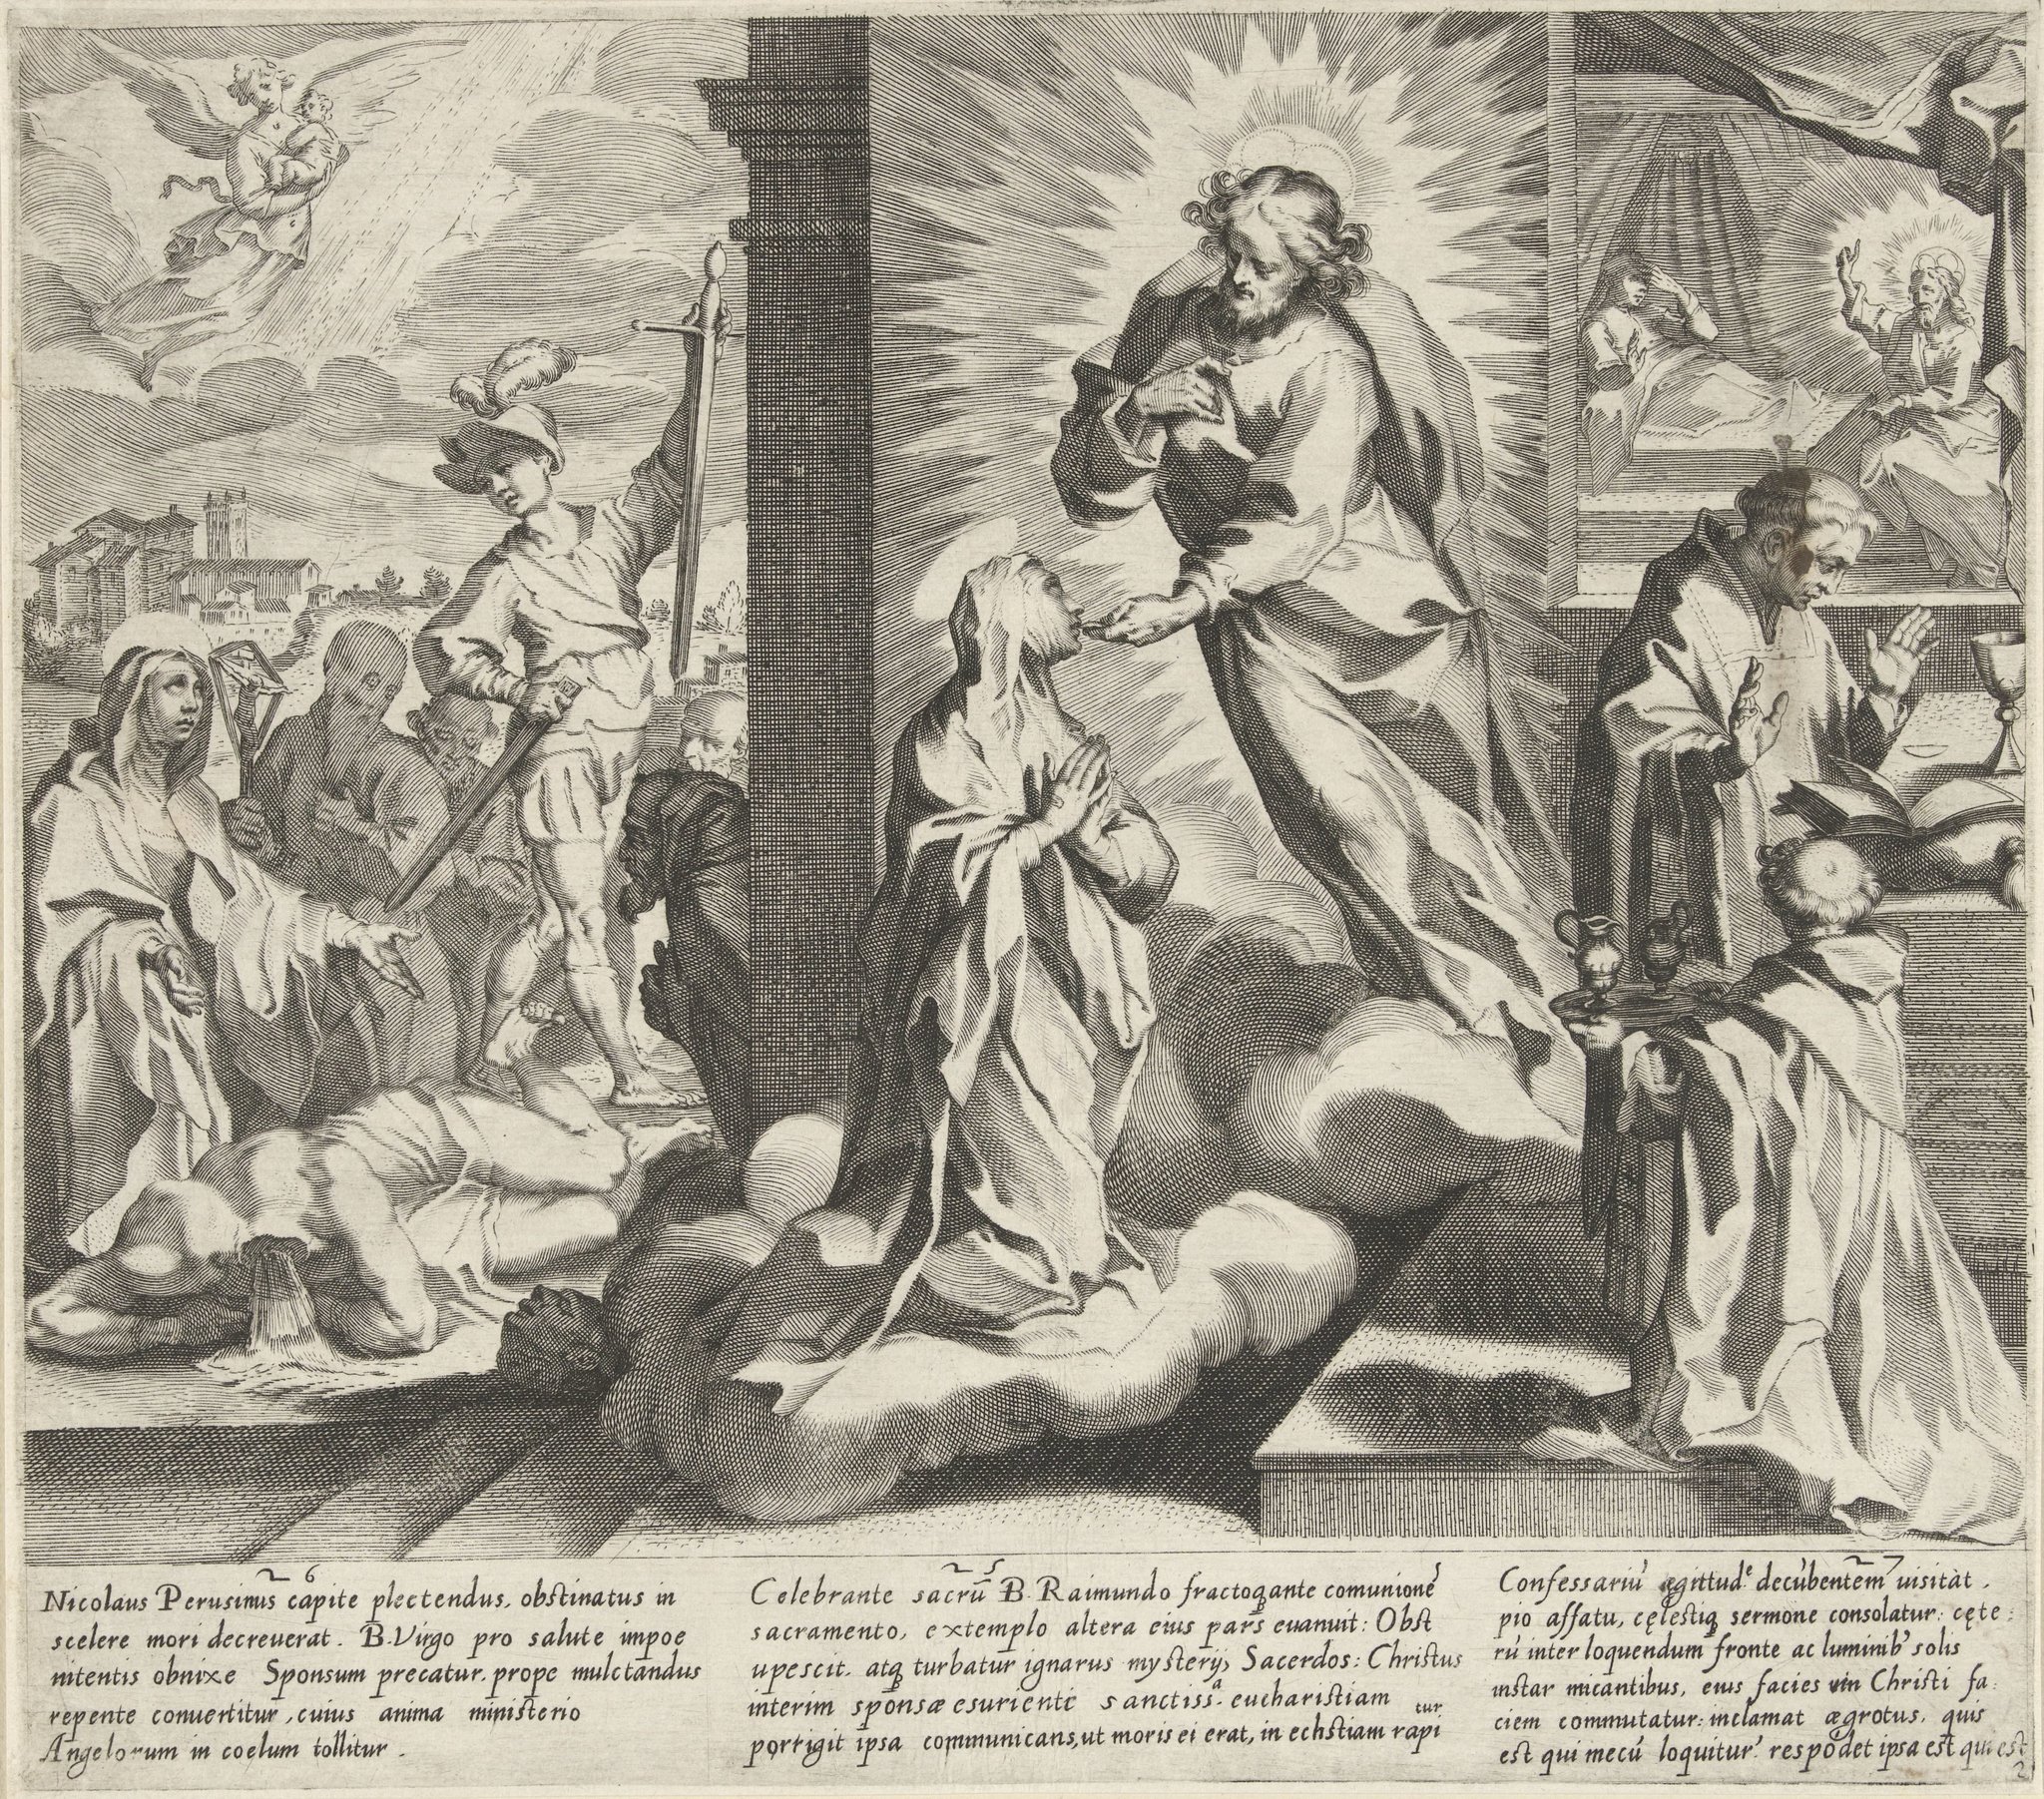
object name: print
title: Vita mors gesta, et miracula quaedam selecta B. CATHERINAE SENENSIS (...)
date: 1597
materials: paper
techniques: engraving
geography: italy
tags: the virgin and dominican tertiary, catherine of siena; possible attributes: book, cross, crown of thorns, crucifix, demon under foot, heart (with cross), lily, plague-stricken, ring, rosary, stigmata, st. catherine of siena receives the communion from christ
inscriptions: collector's mark: Lugt 240